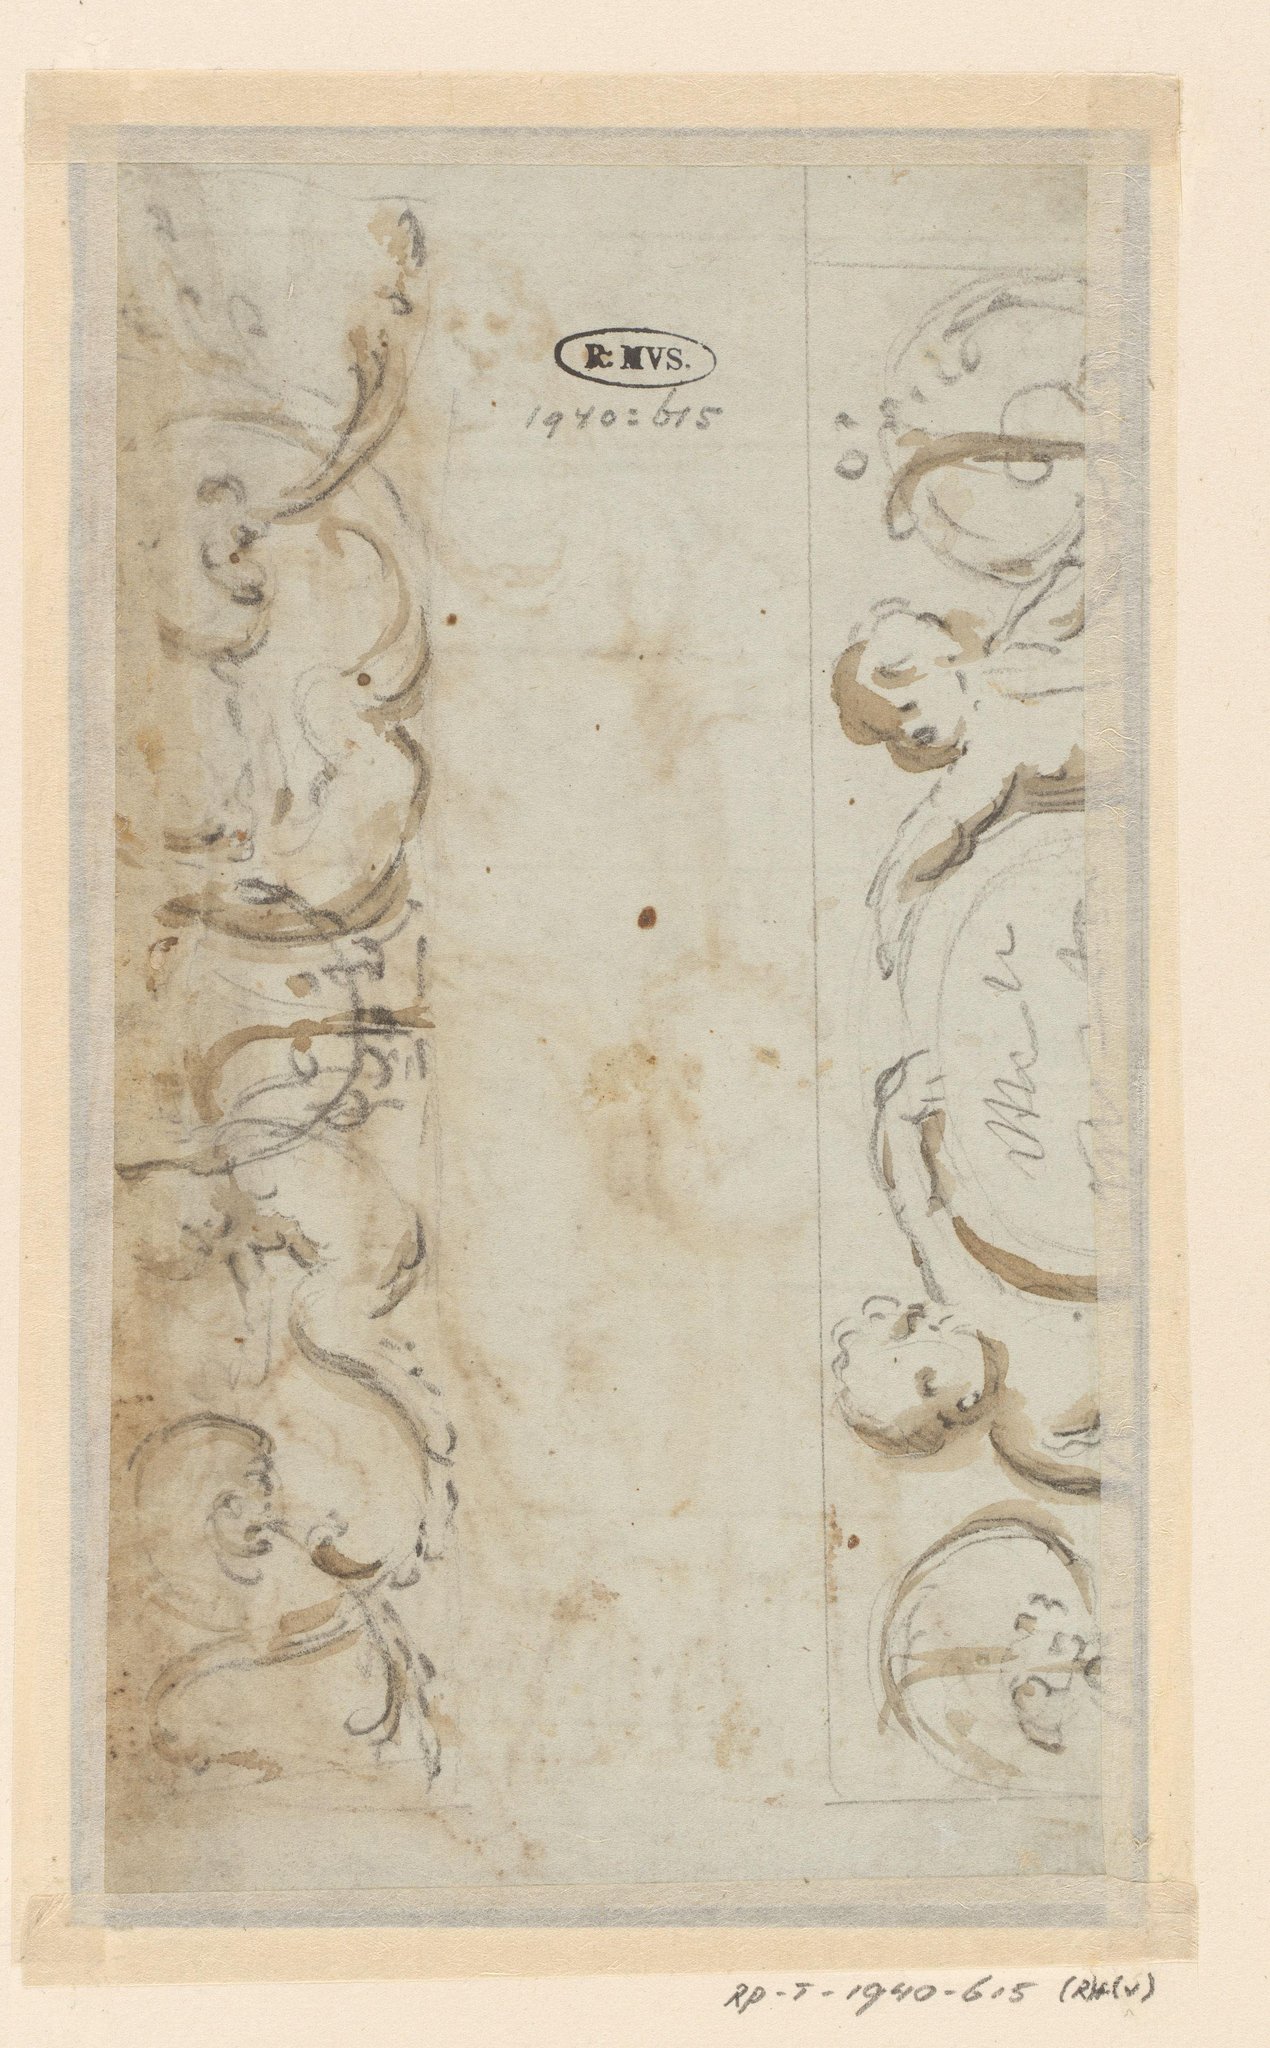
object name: drawing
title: Fragment van een ornament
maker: guillaume-jacques herreyns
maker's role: draughtsman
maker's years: 1743-1827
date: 1753-1827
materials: chalk, paper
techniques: brush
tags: ornaments ~ art